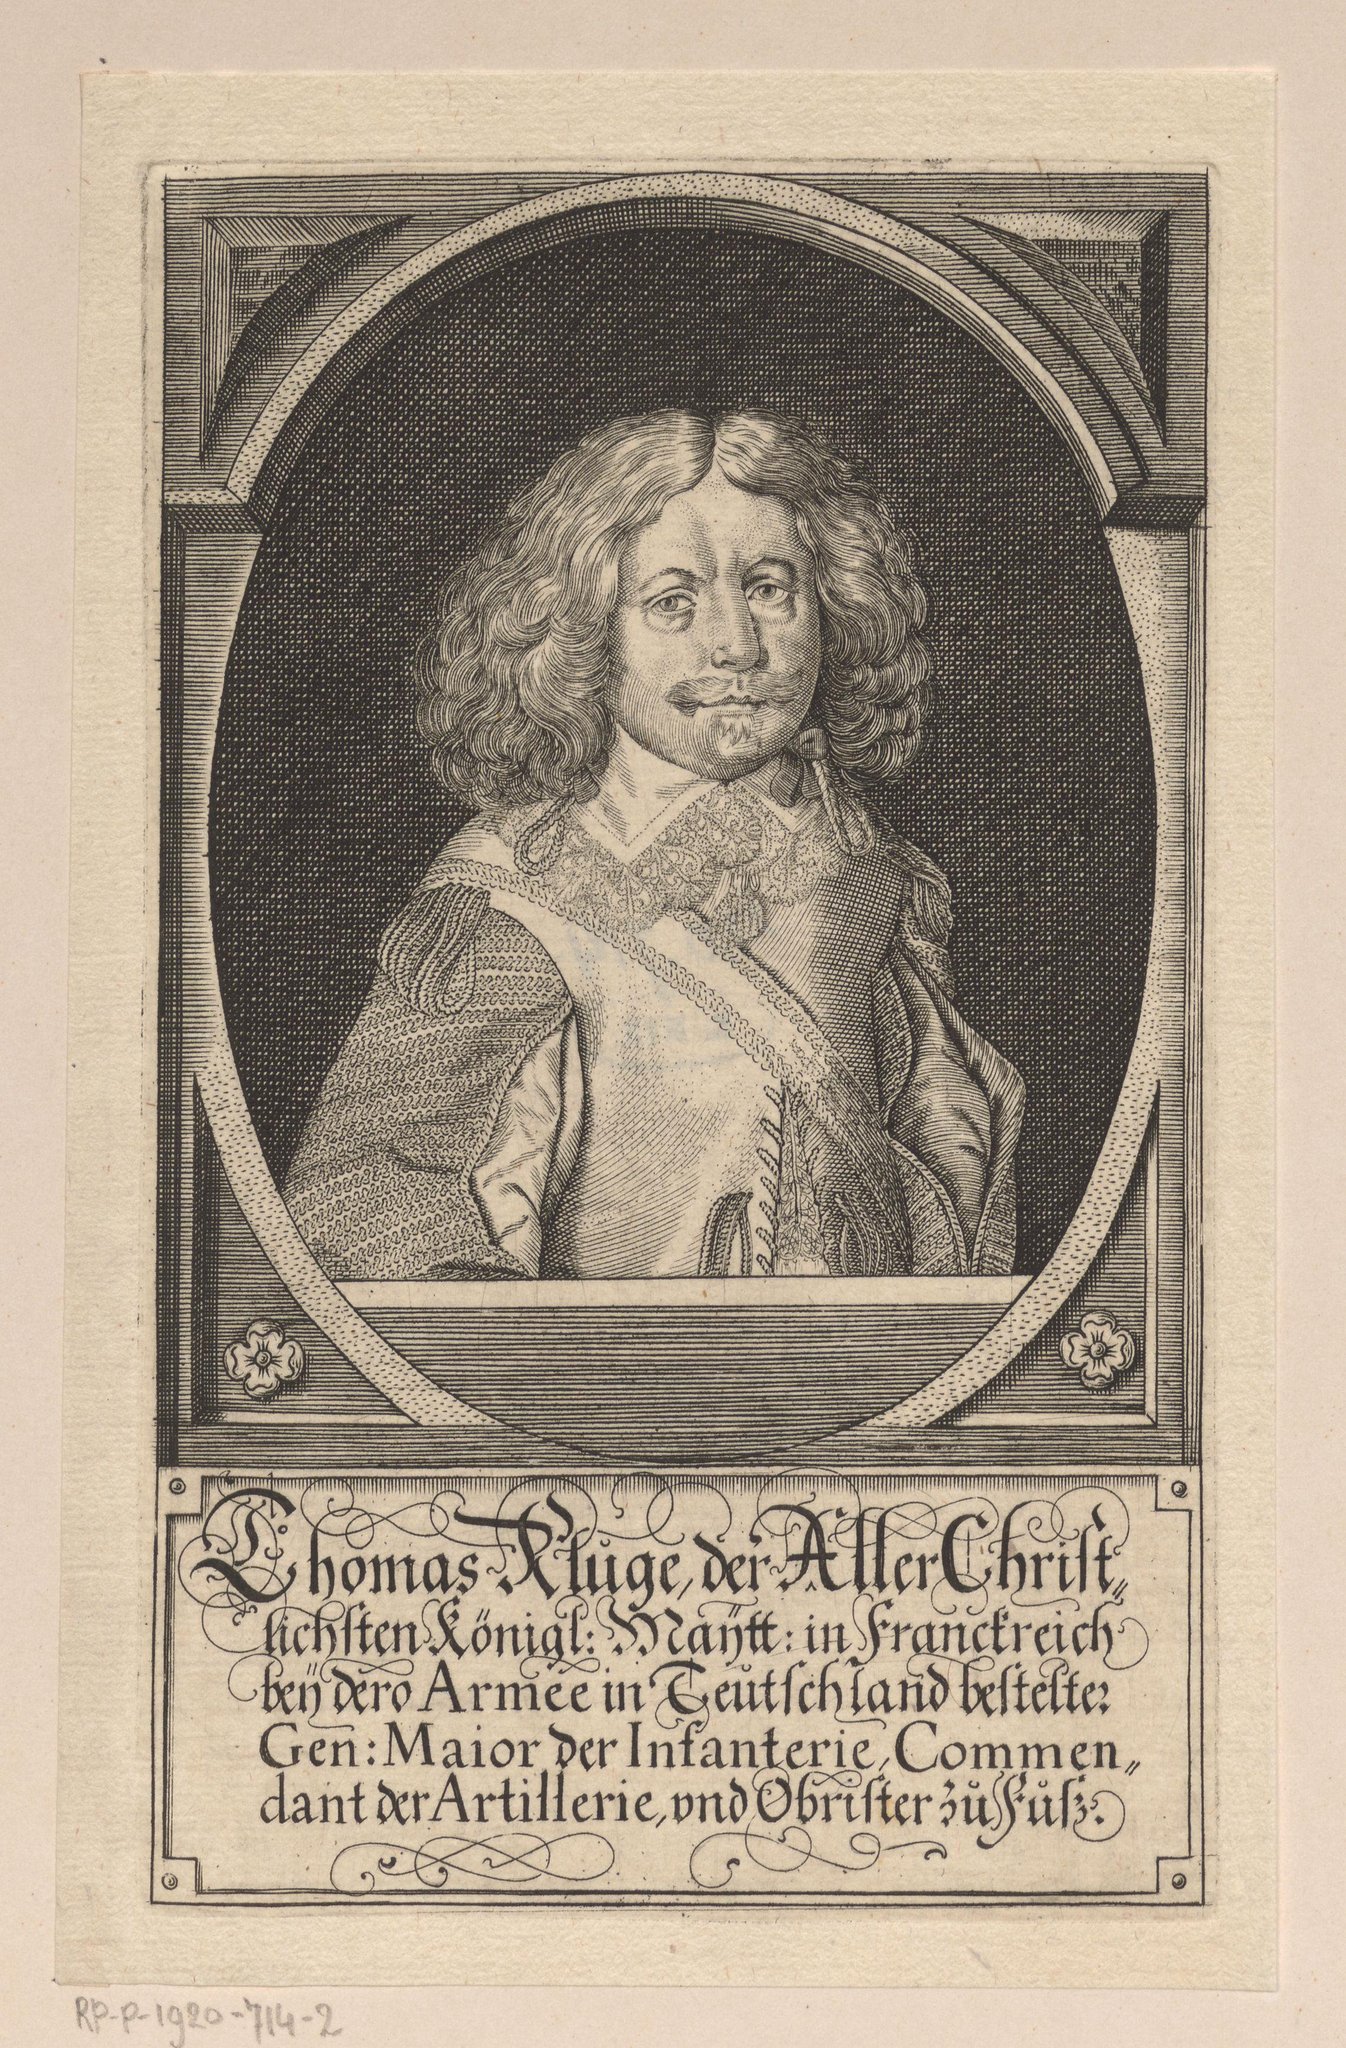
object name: print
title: Portret van Paul Stirn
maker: Anonymous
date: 1655-1749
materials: paper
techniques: engraving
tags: historical persons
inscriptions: collector's mark: Lugt 2228